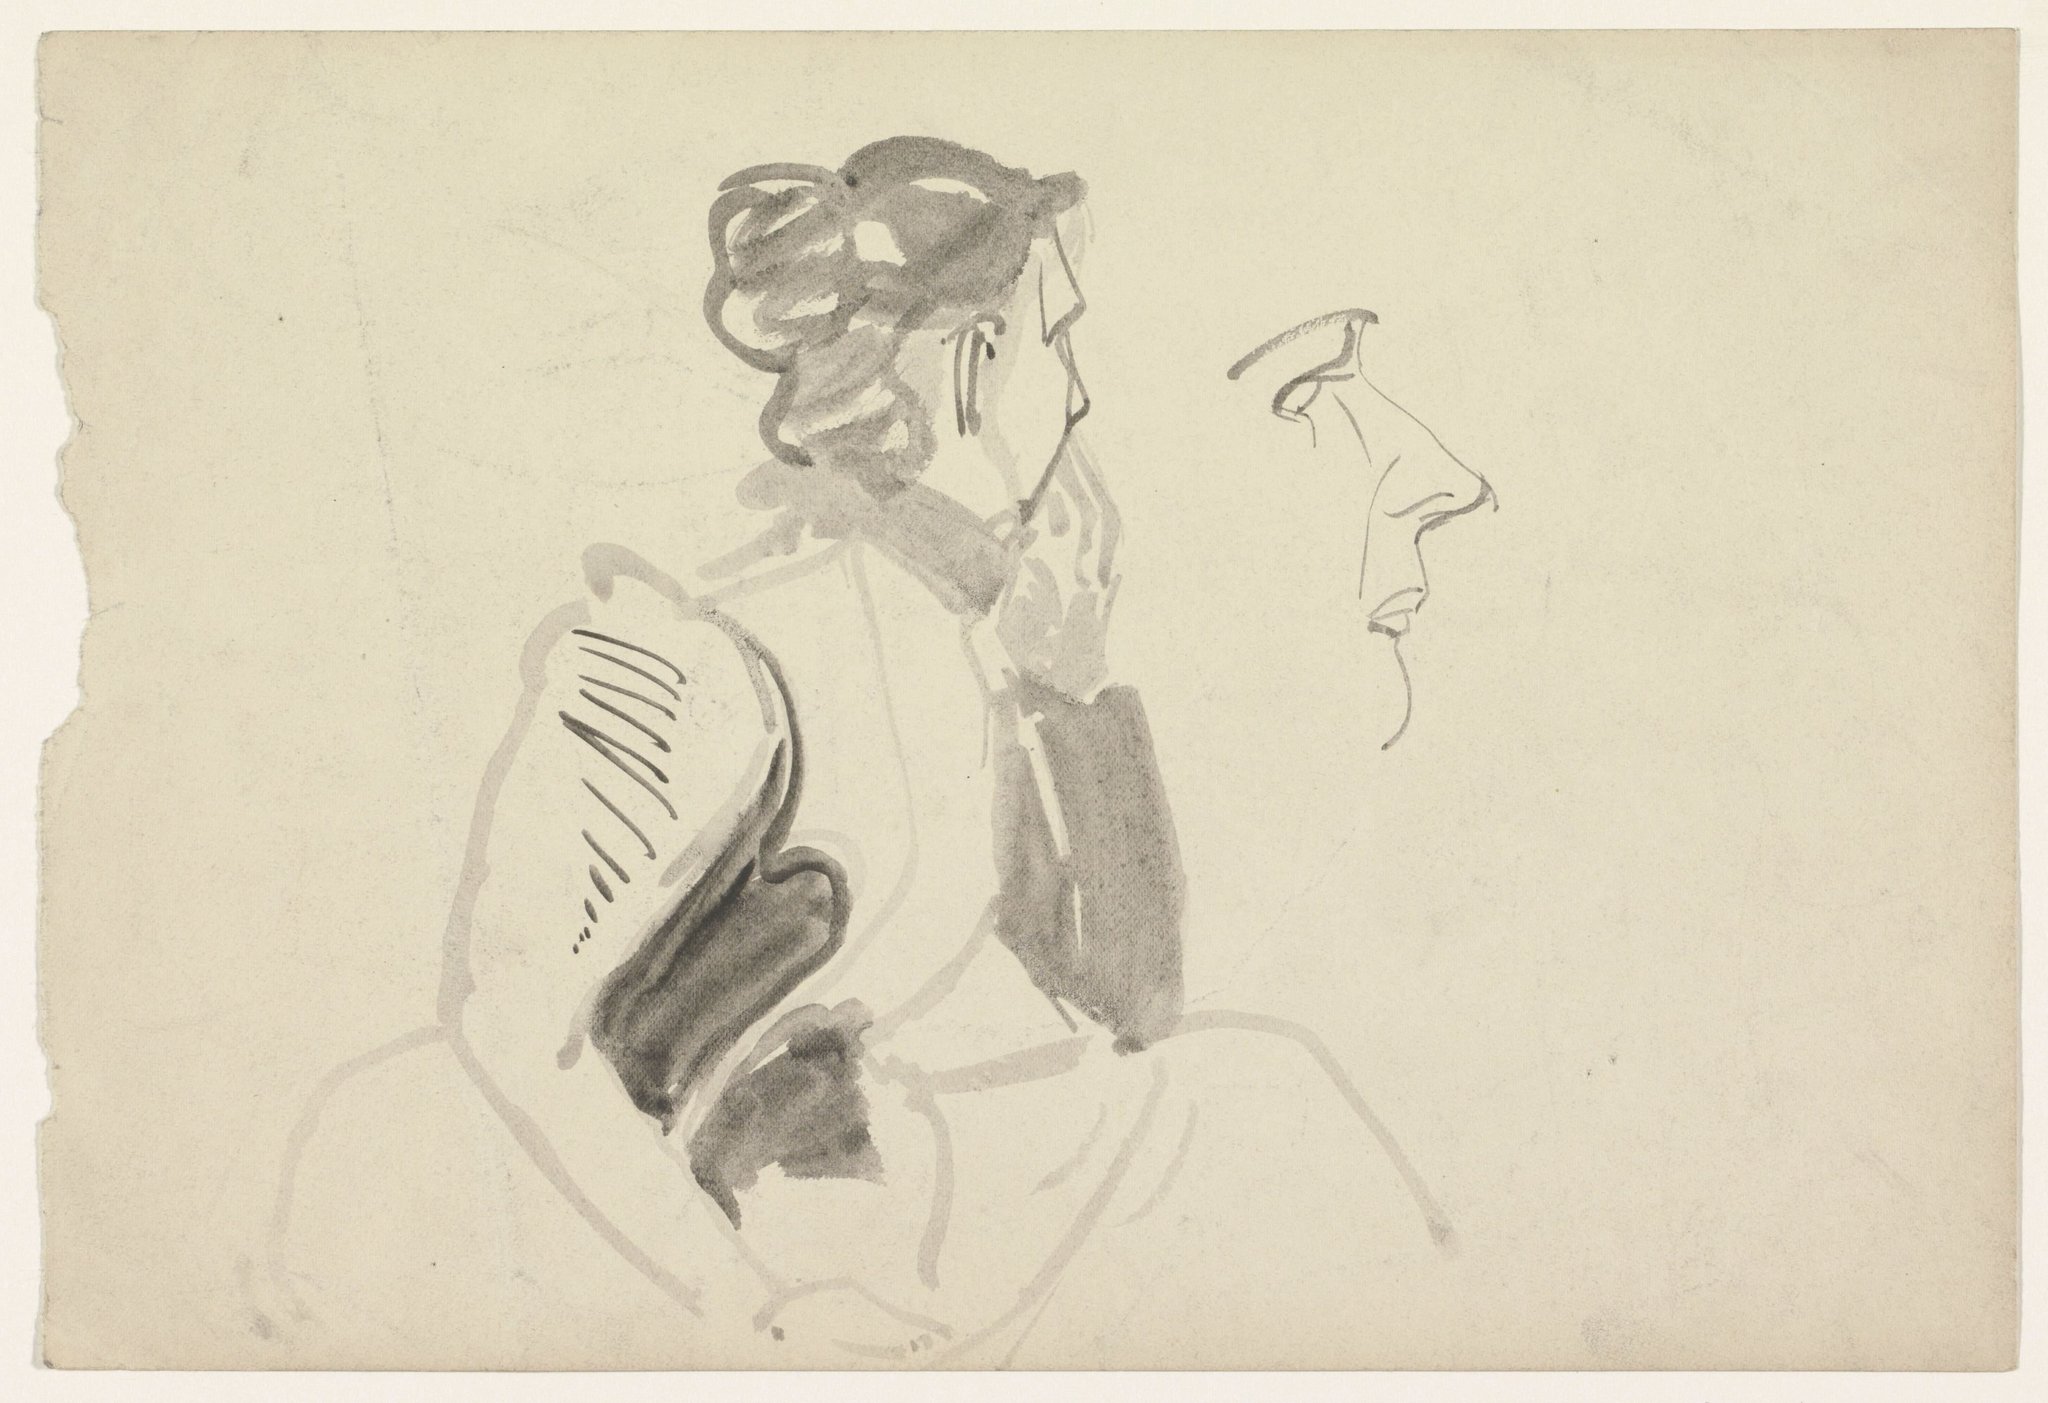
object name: drawing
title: Studie van een zittende vrouw met afgewend gezicht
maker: carel adolph lion cachet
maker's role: draughtsman, print maker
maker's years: 1864-1945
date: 1874-1945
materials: paper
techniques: brush